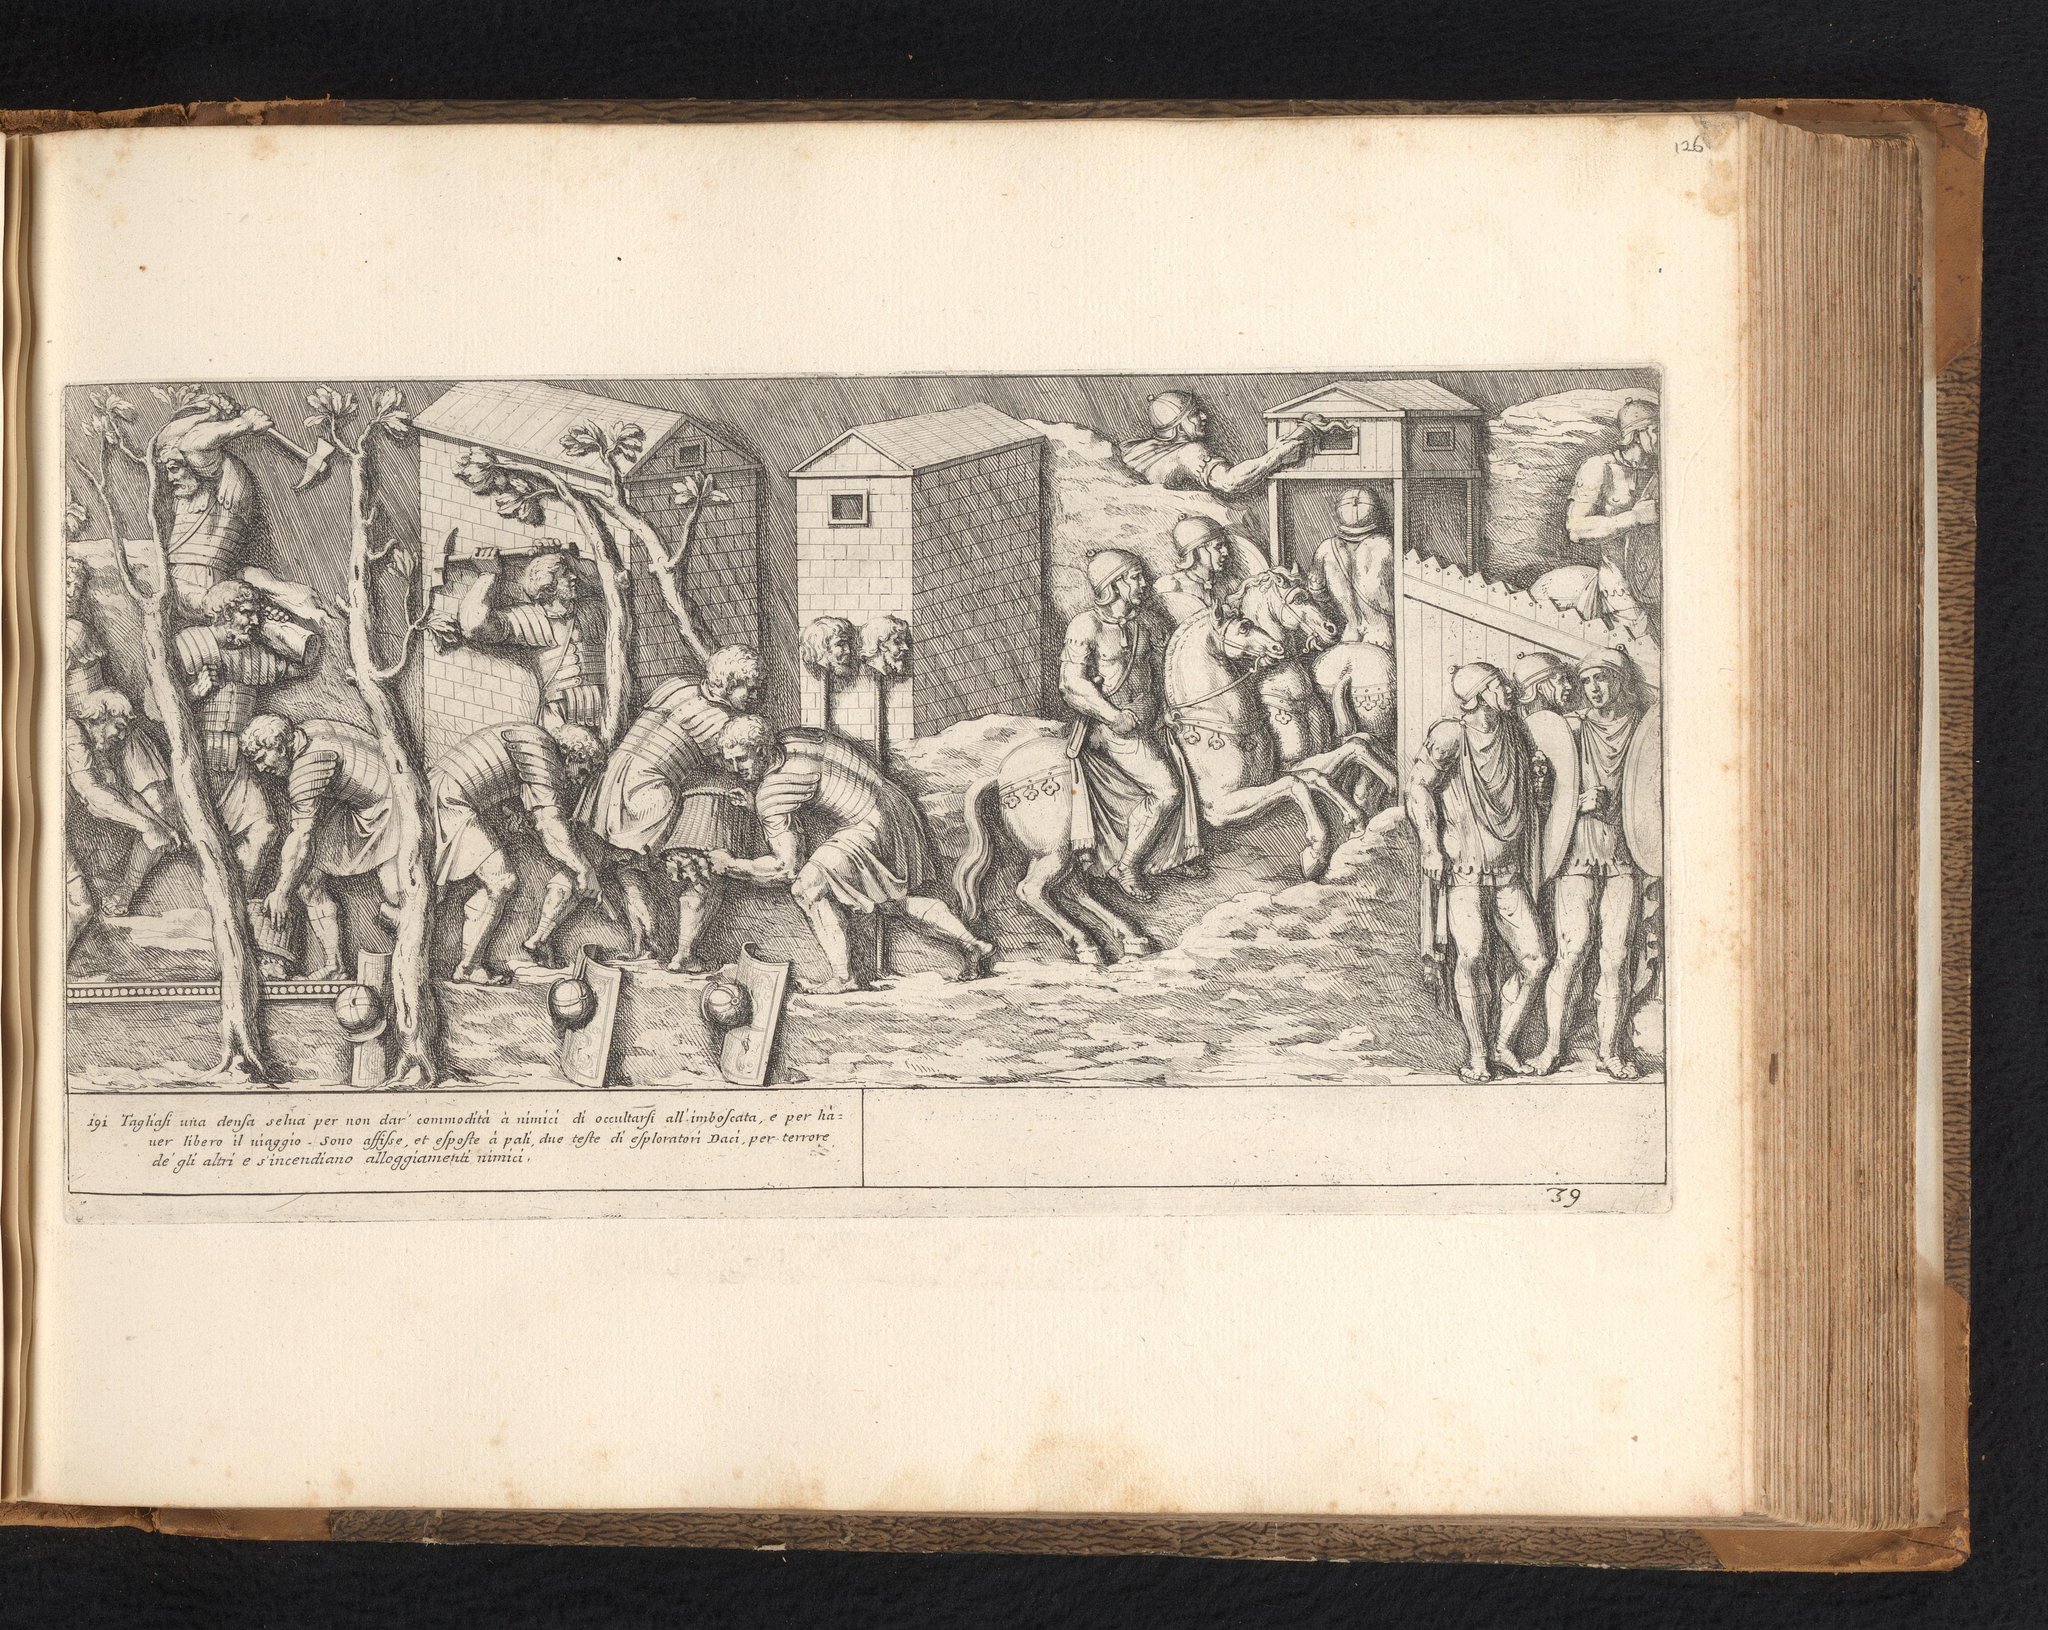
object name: album leaf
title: Colonna Traiana eretta dal senato, e popolo Romano all' imperatore Traiano Augusto nel suo foro in Rom (...)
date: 1637-1691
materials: paper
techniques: etching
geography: vatican city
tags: triumphal column with helical friezes, piece of sculpture, reproduction of a piece of sculpture, the soldier; the soldier's life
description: Detail van het spiraalvormige gebeeldhouwde fries op de Zuil van Trajanus. Het fries toont de oorlogen tussen de Romeinen en de Daciërs. Verklarende nummers in de ondermarge. Prent maakt deel uit van een album.